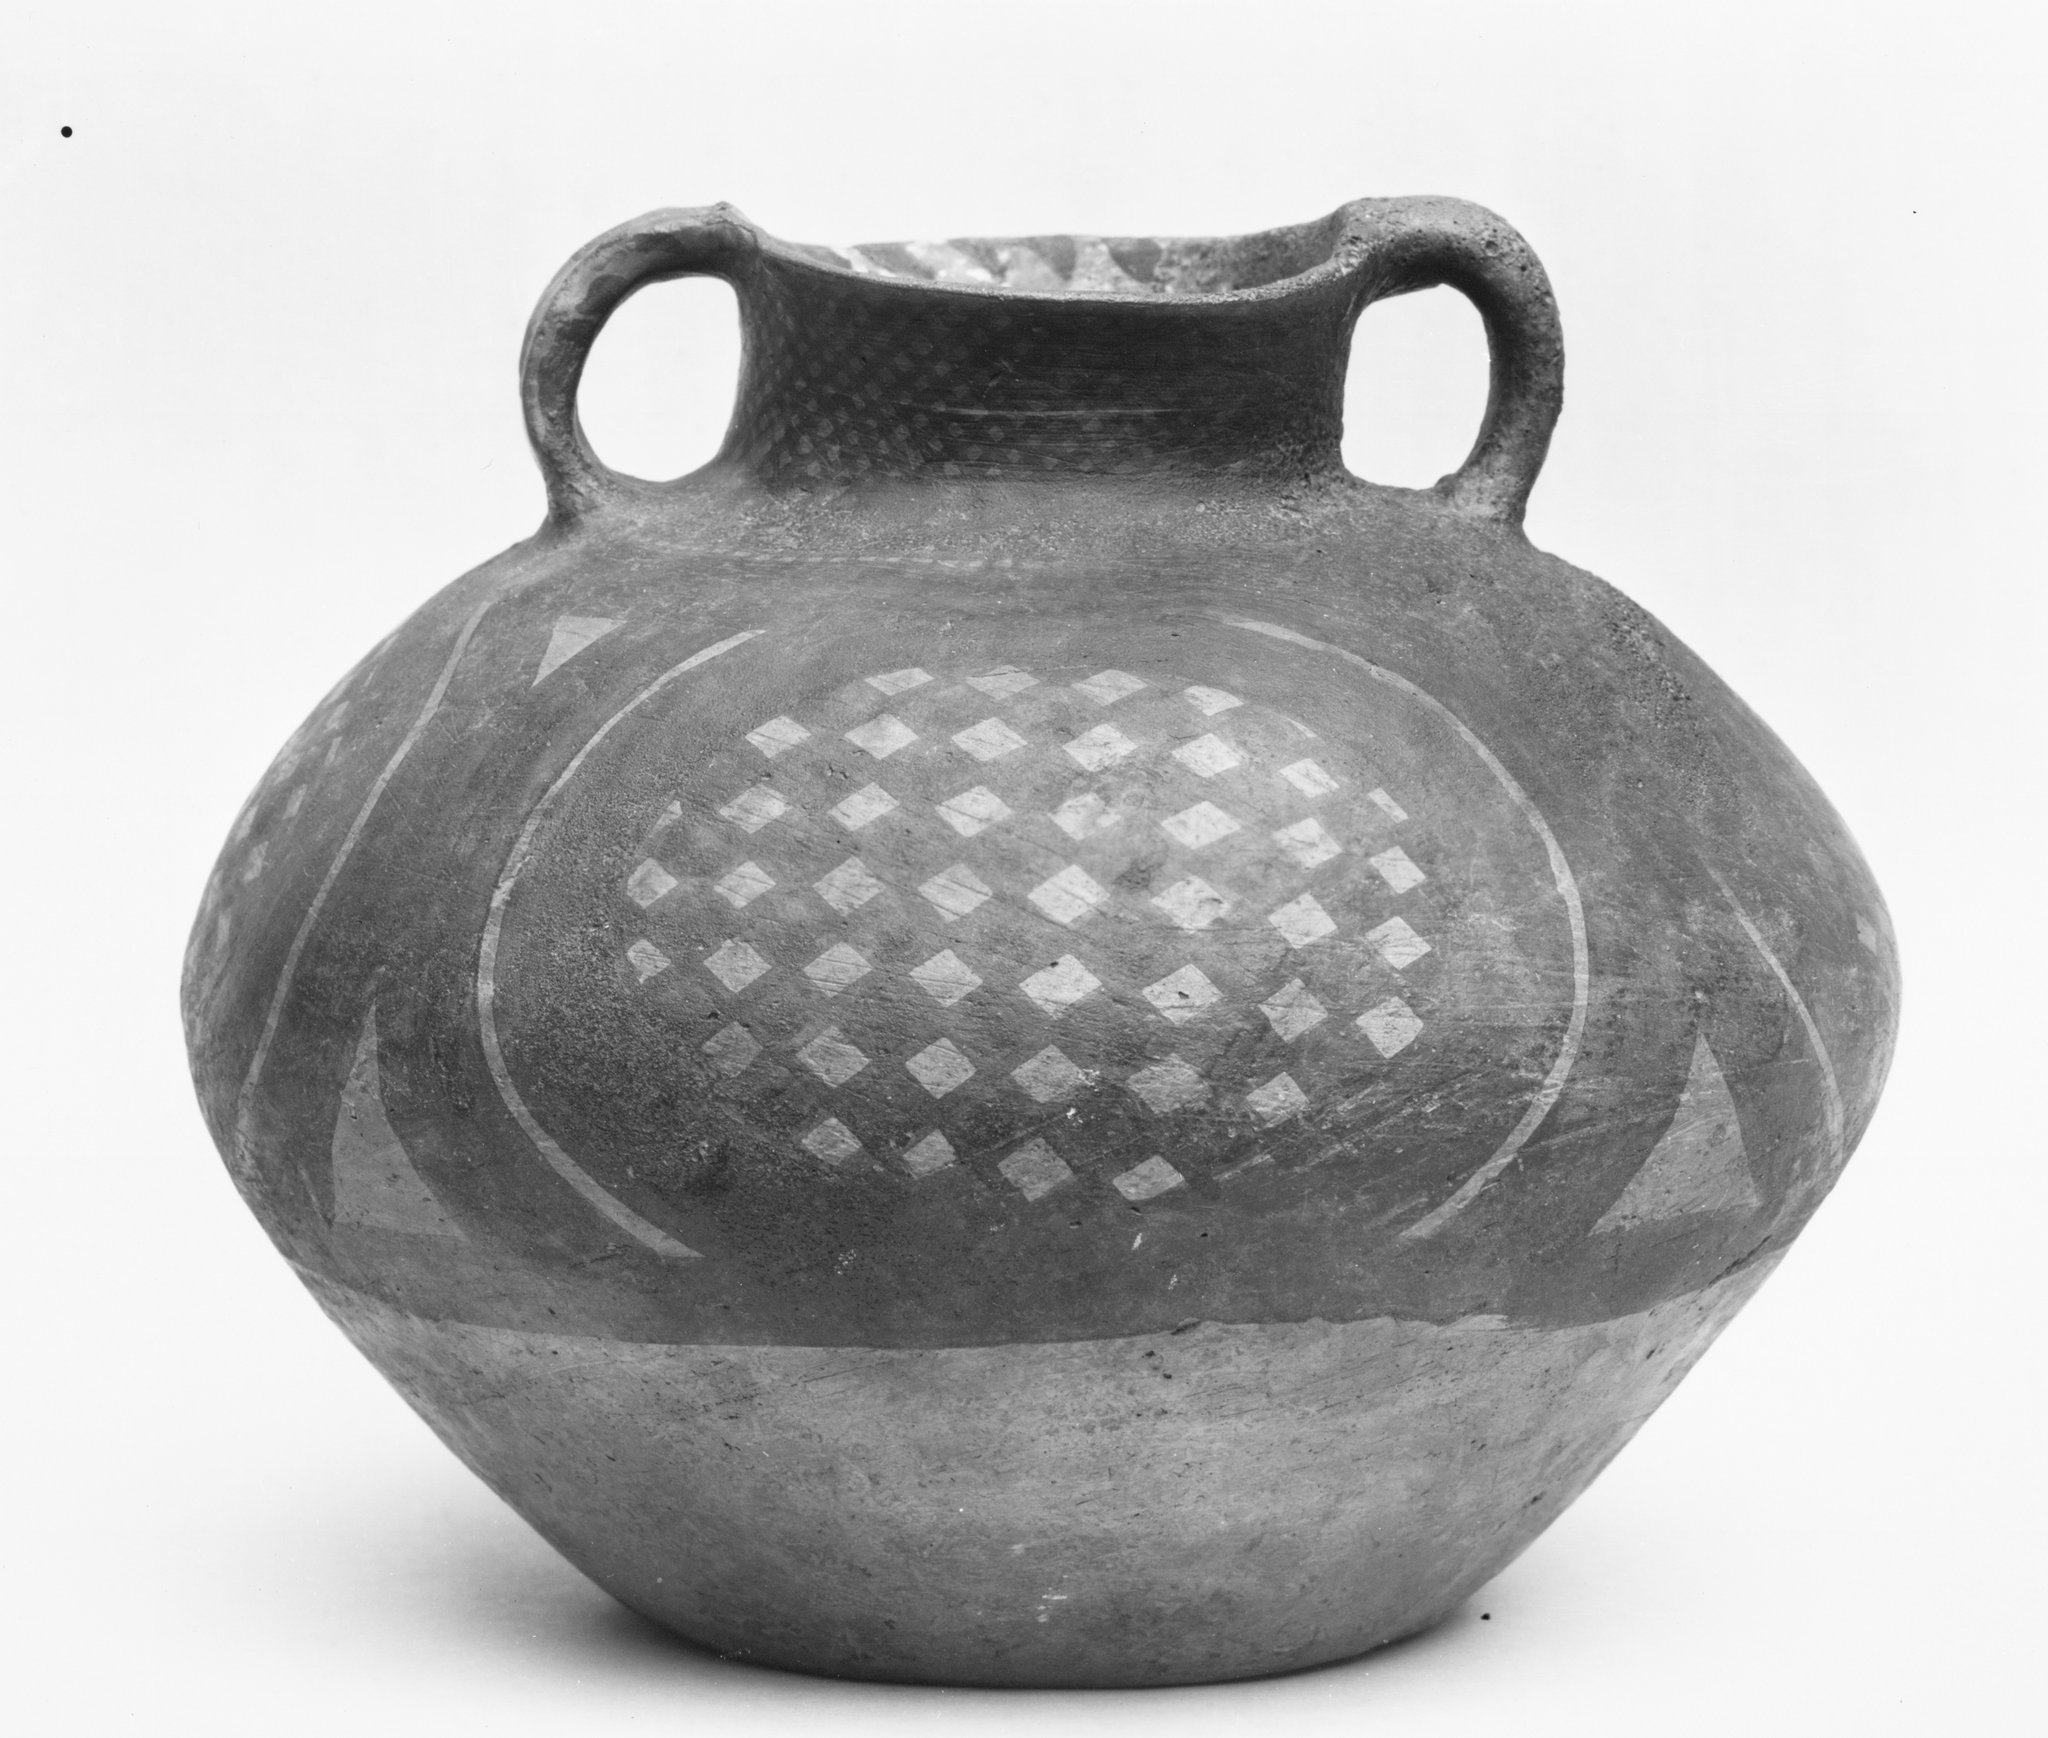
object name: jar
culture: chinese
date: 2000 BCE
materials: pottery